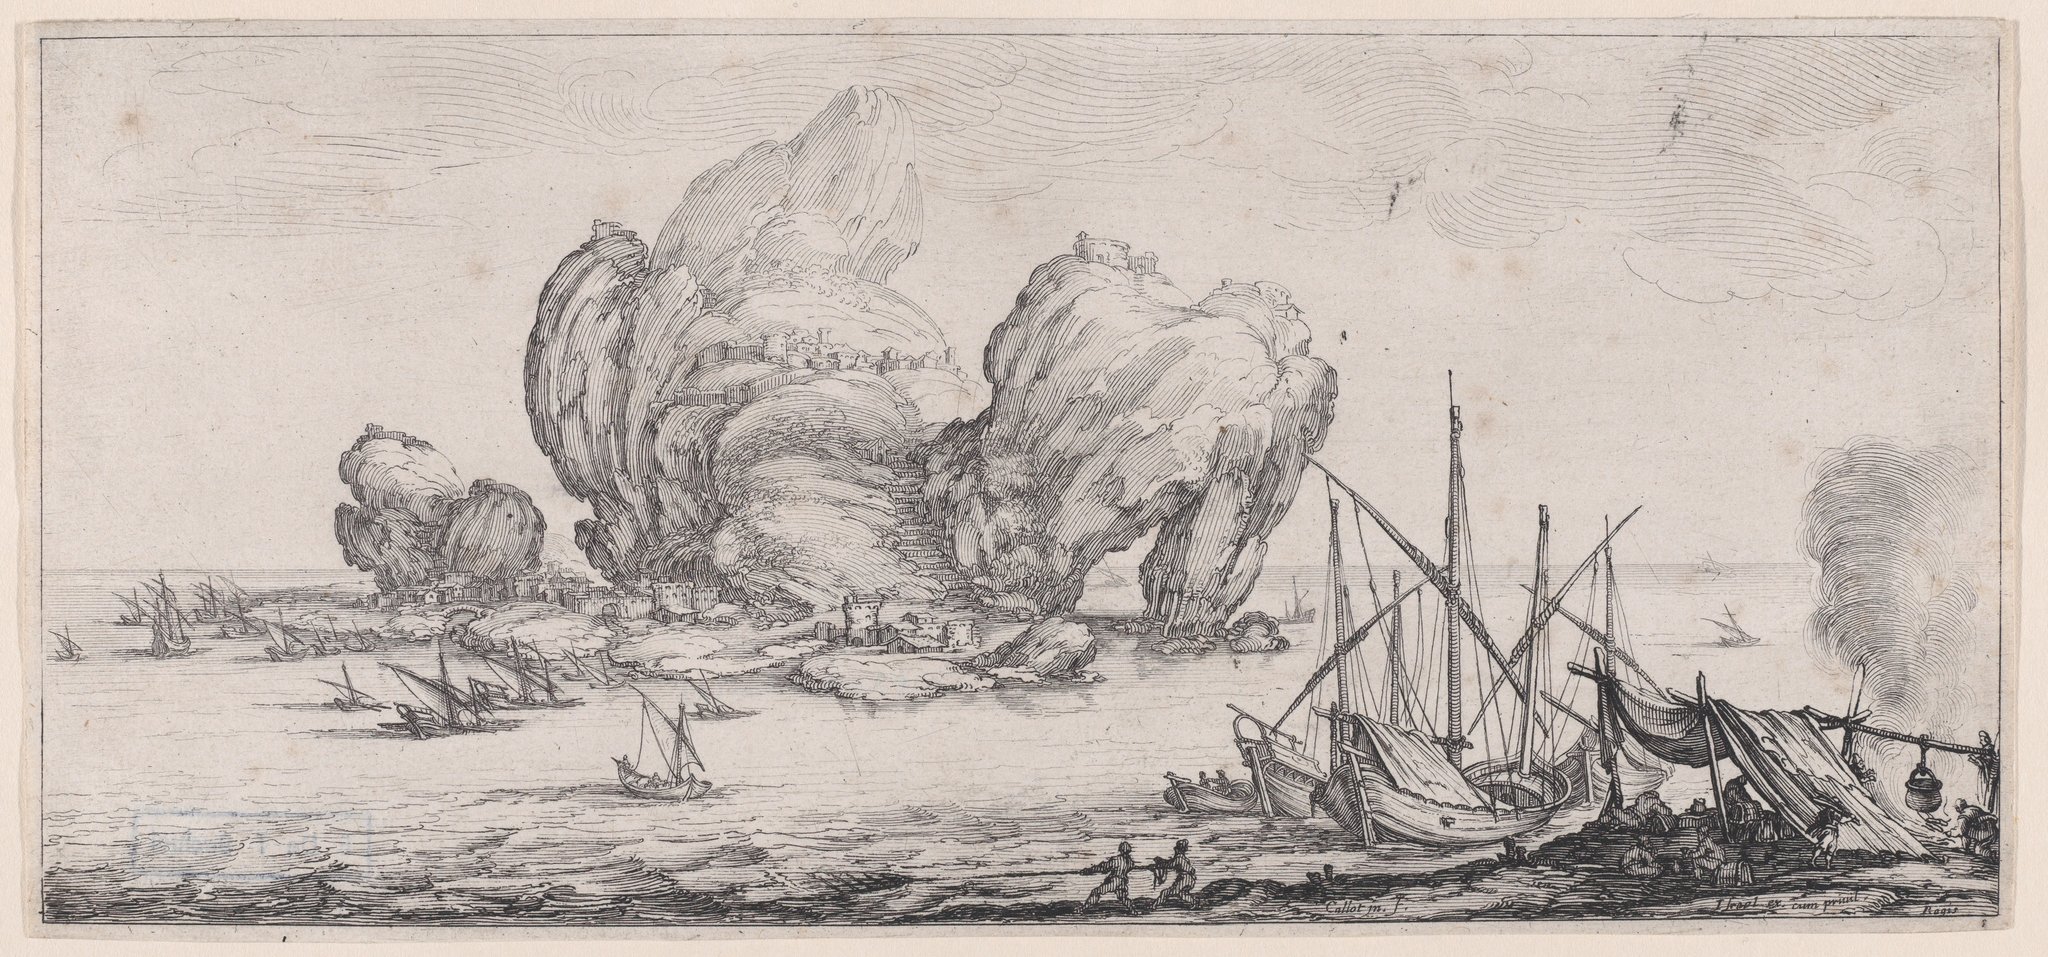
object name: print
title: Le Grand Rocher (The Large Rock), from "Paysages Gravés pour Jean de Médicis appelées aussi Paysages Dessinés a Florence, Vues de Florence, Paysages d'Italie, et Paysages Définitifs" (Landscapes Engraved for Giovanni de'Medici, Landscapes Designed in Florence, Views of Florence, Landscapes of Italy, and Definitive Landscapes)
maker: jacques callot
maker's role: artist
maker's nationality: french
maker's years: 1592-1635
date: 1618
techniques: etching